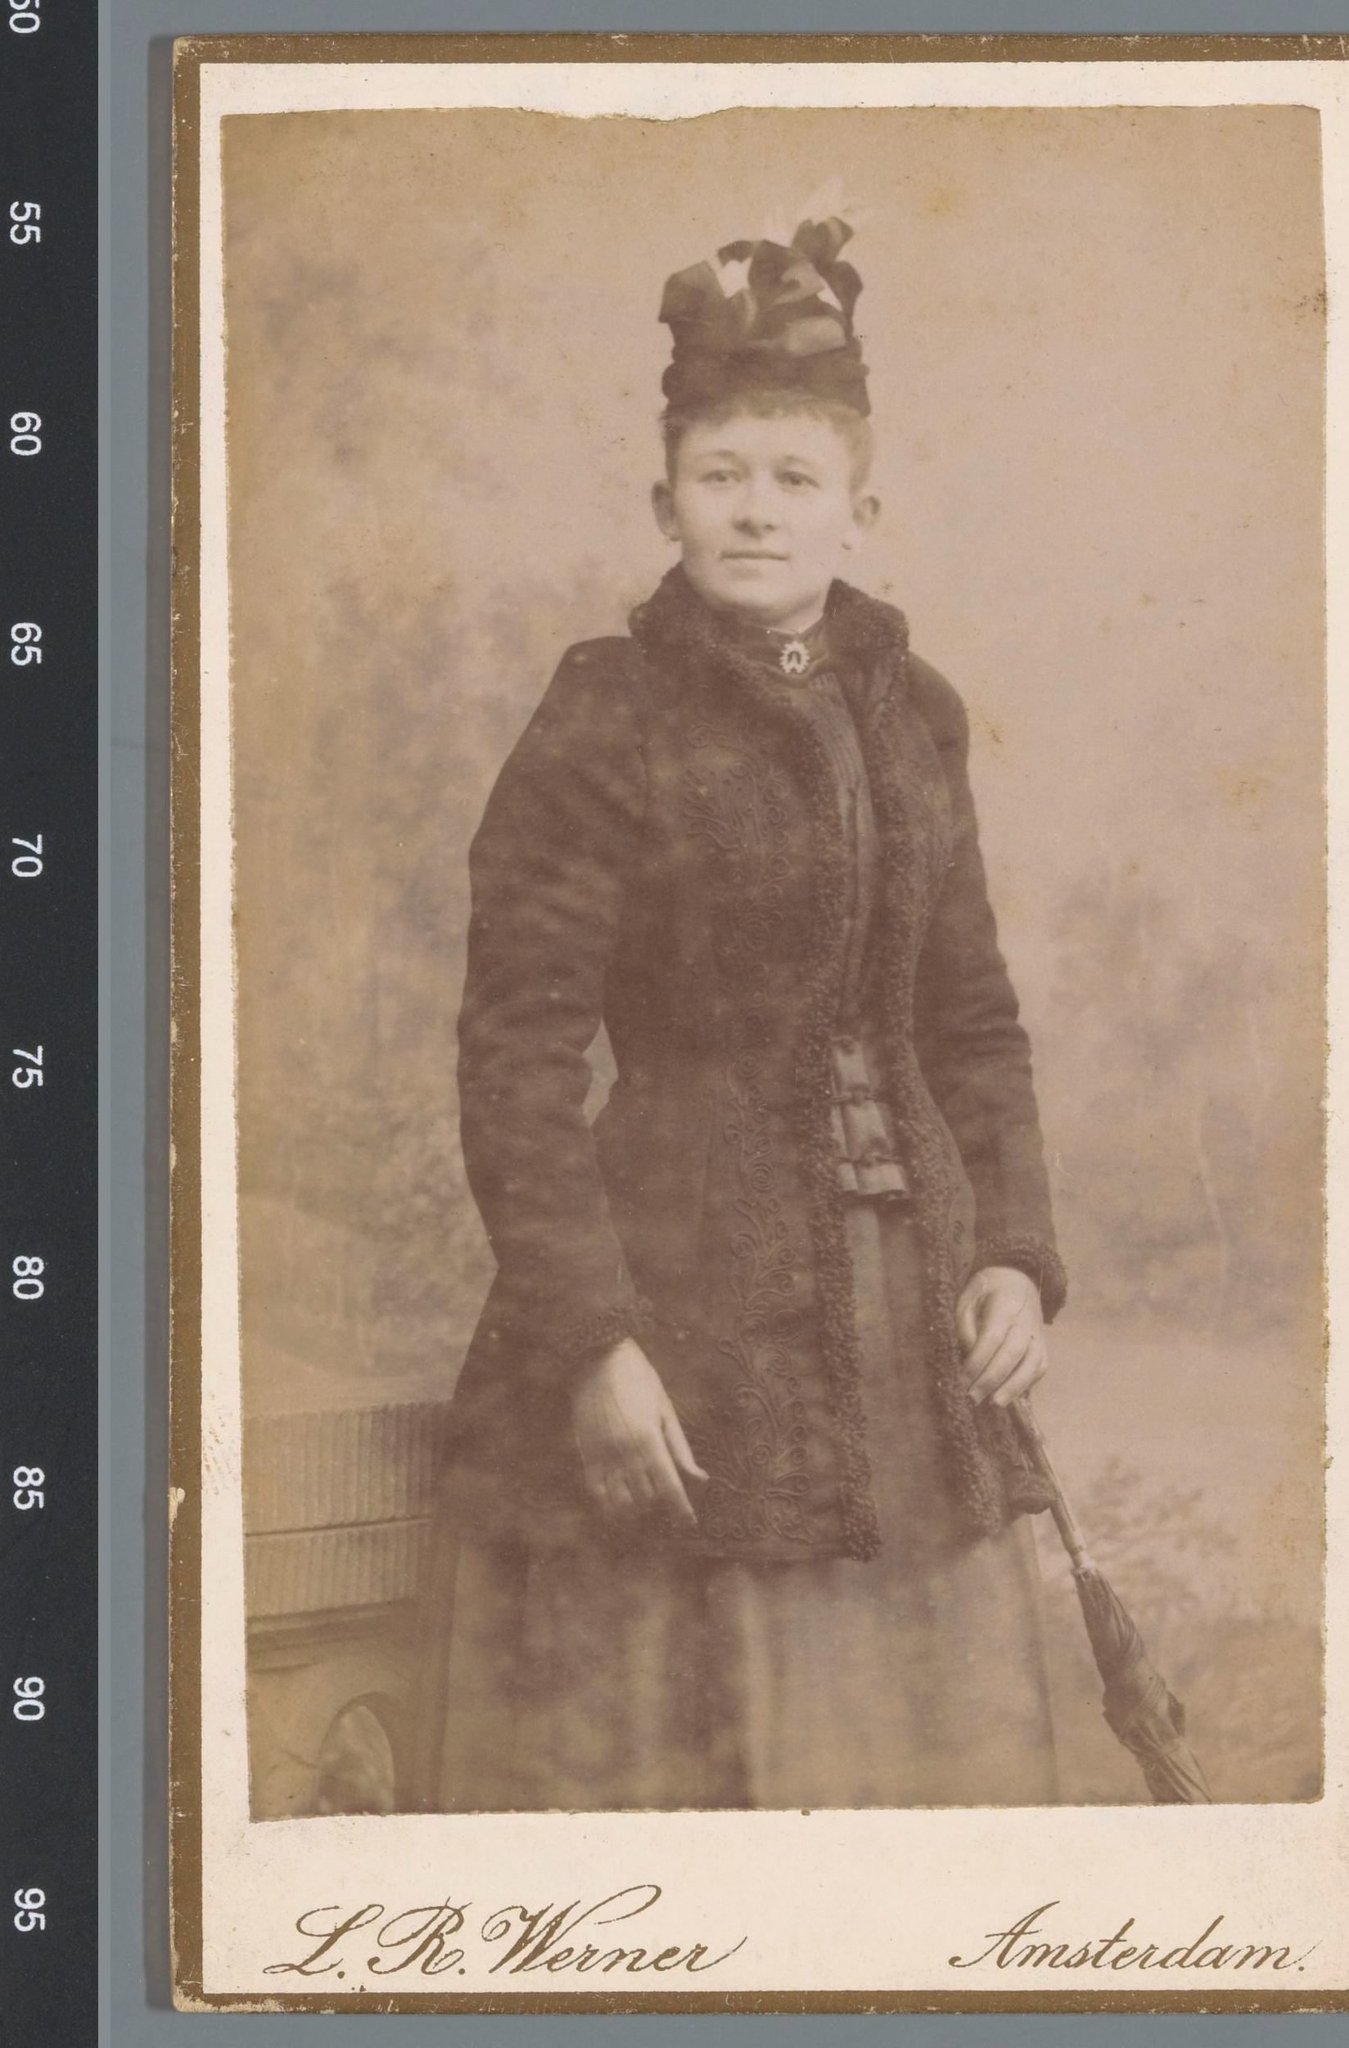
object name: carte de visite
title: Portret van een onbekende jonge vrouw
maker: louis robert werner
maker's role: fotograaf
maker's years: 1834-1896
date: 1878-1886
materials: cardboard, paper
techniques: albumen print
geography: amsterdam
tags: adolescent, young woman, maiden, anonymous historical person portrayed, amsterdam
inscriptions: inscription: ‘L.R. Werner Amsterdam.’, inscription: ‘L.R. Werner/ voorheen P. Carstensen/ Amsterdam/ Nieuwendijk H.150./ Nabestellingen en Vergrotingen,/ ook van anderen Portretten, kunnen iederen tijd geleverd worden.’